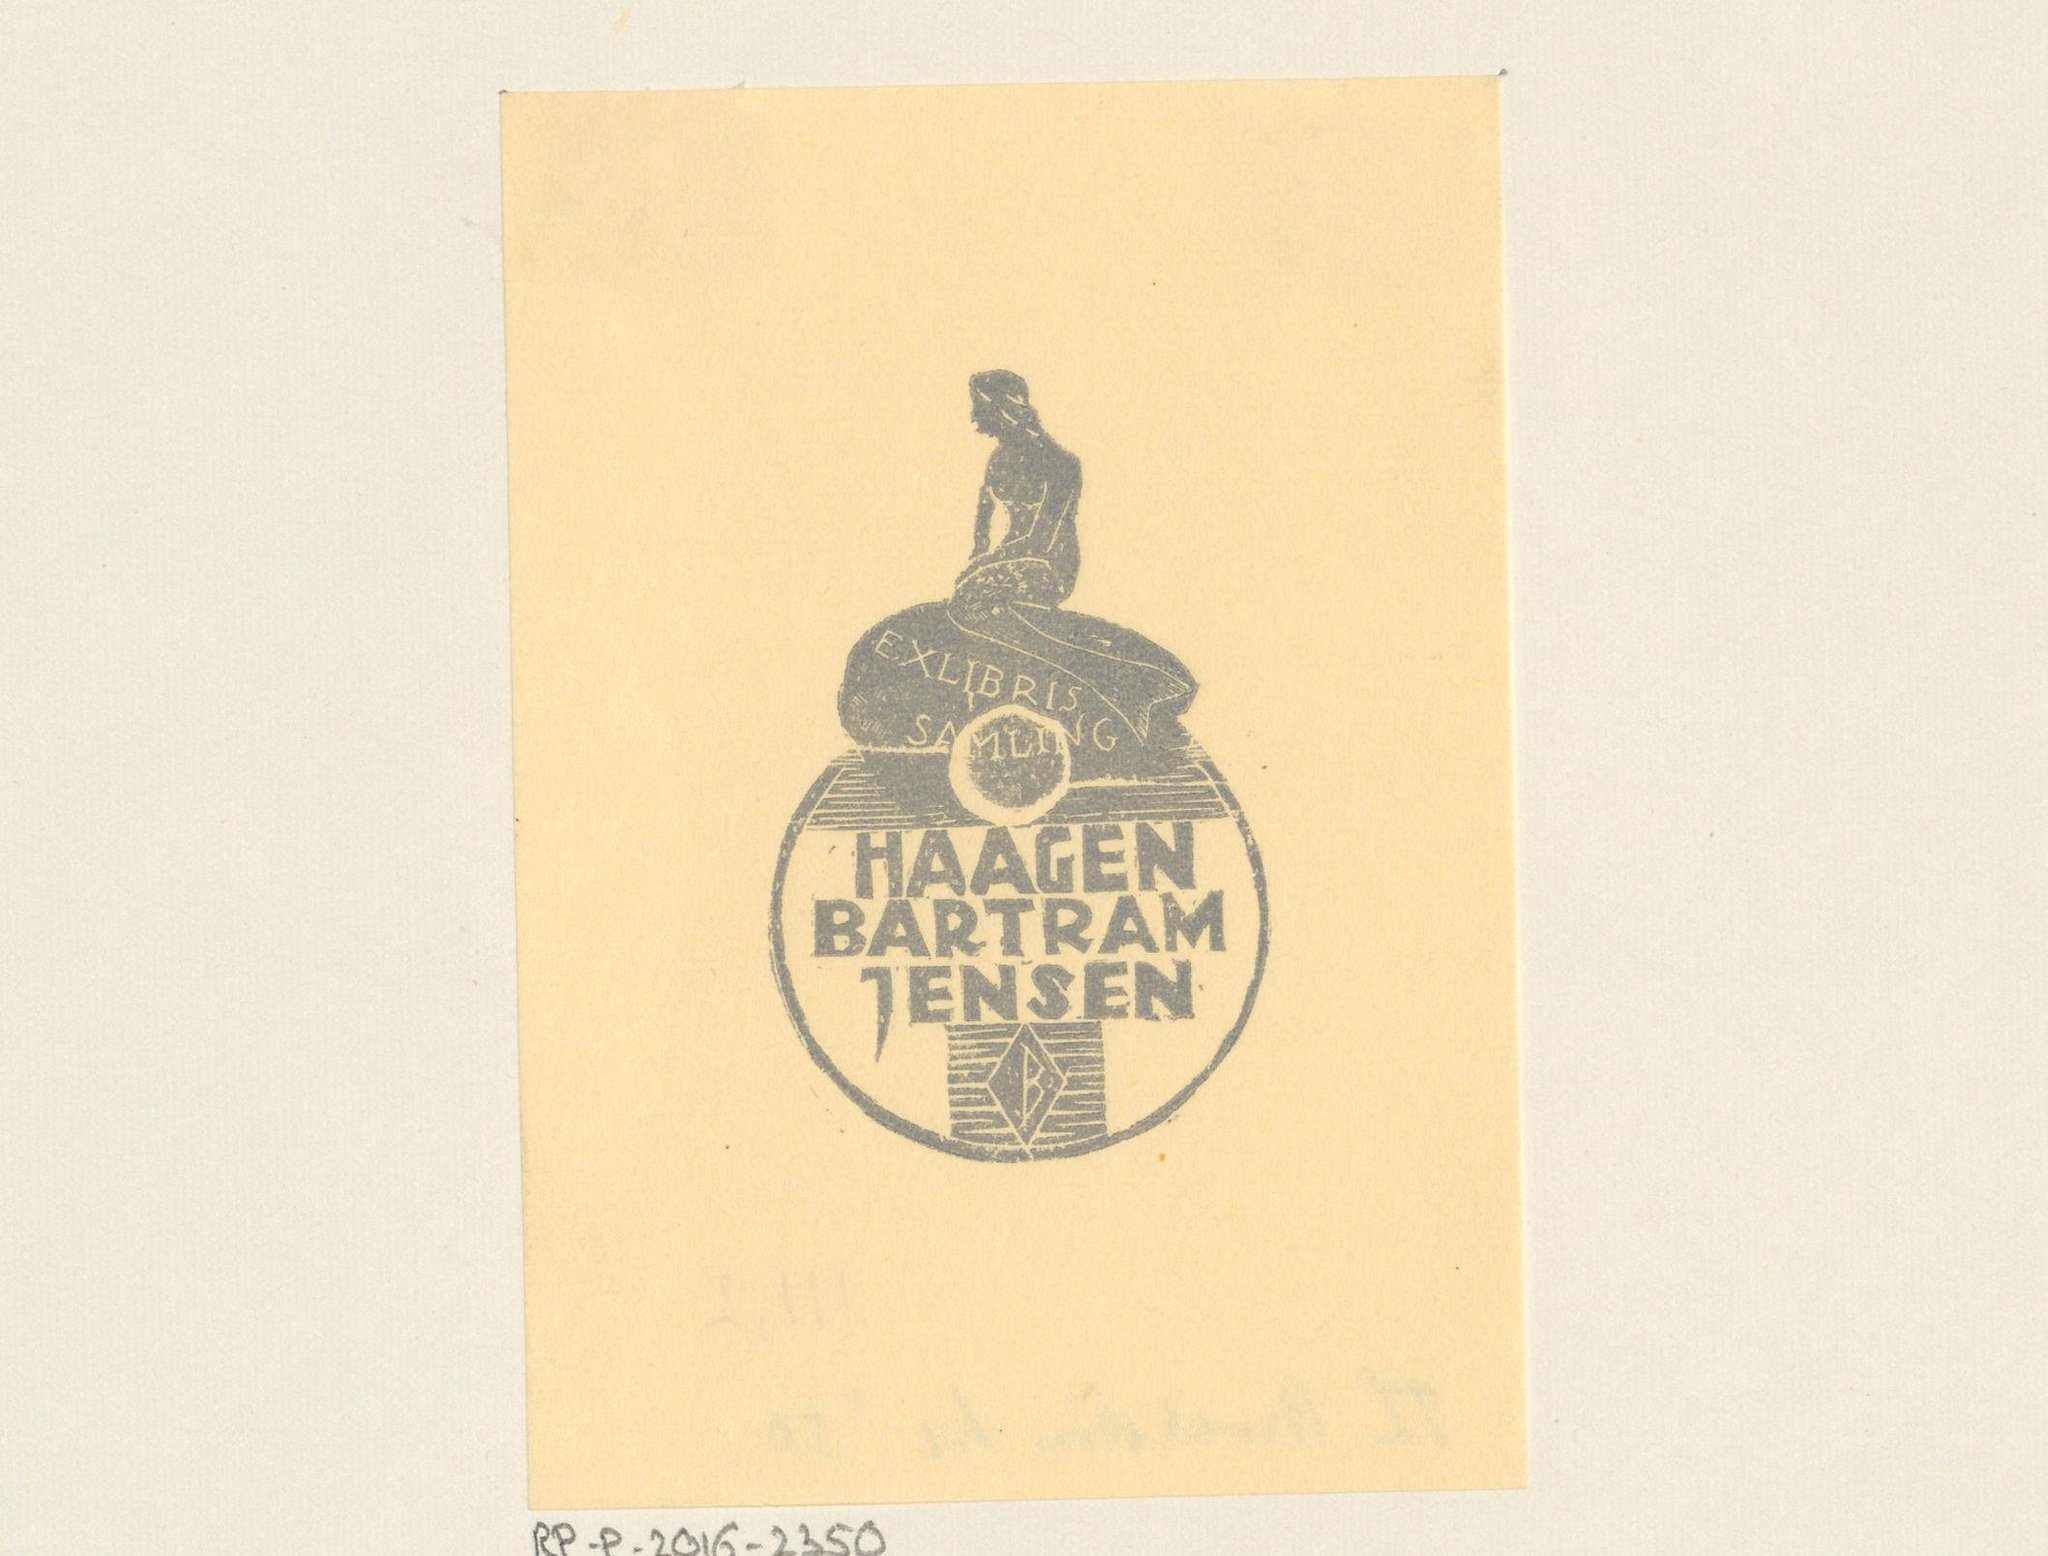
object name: bookplate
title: Ex libris van Haagen Bartram-Jensen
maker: theo broekstra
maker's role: print maker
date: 1950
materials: paper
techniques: woodcut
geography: netherlands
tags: hans christian andersen, merman - aa - mermaid, siren, monument, statue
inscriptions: inscription: ‘Th. Broekstra hs '50’